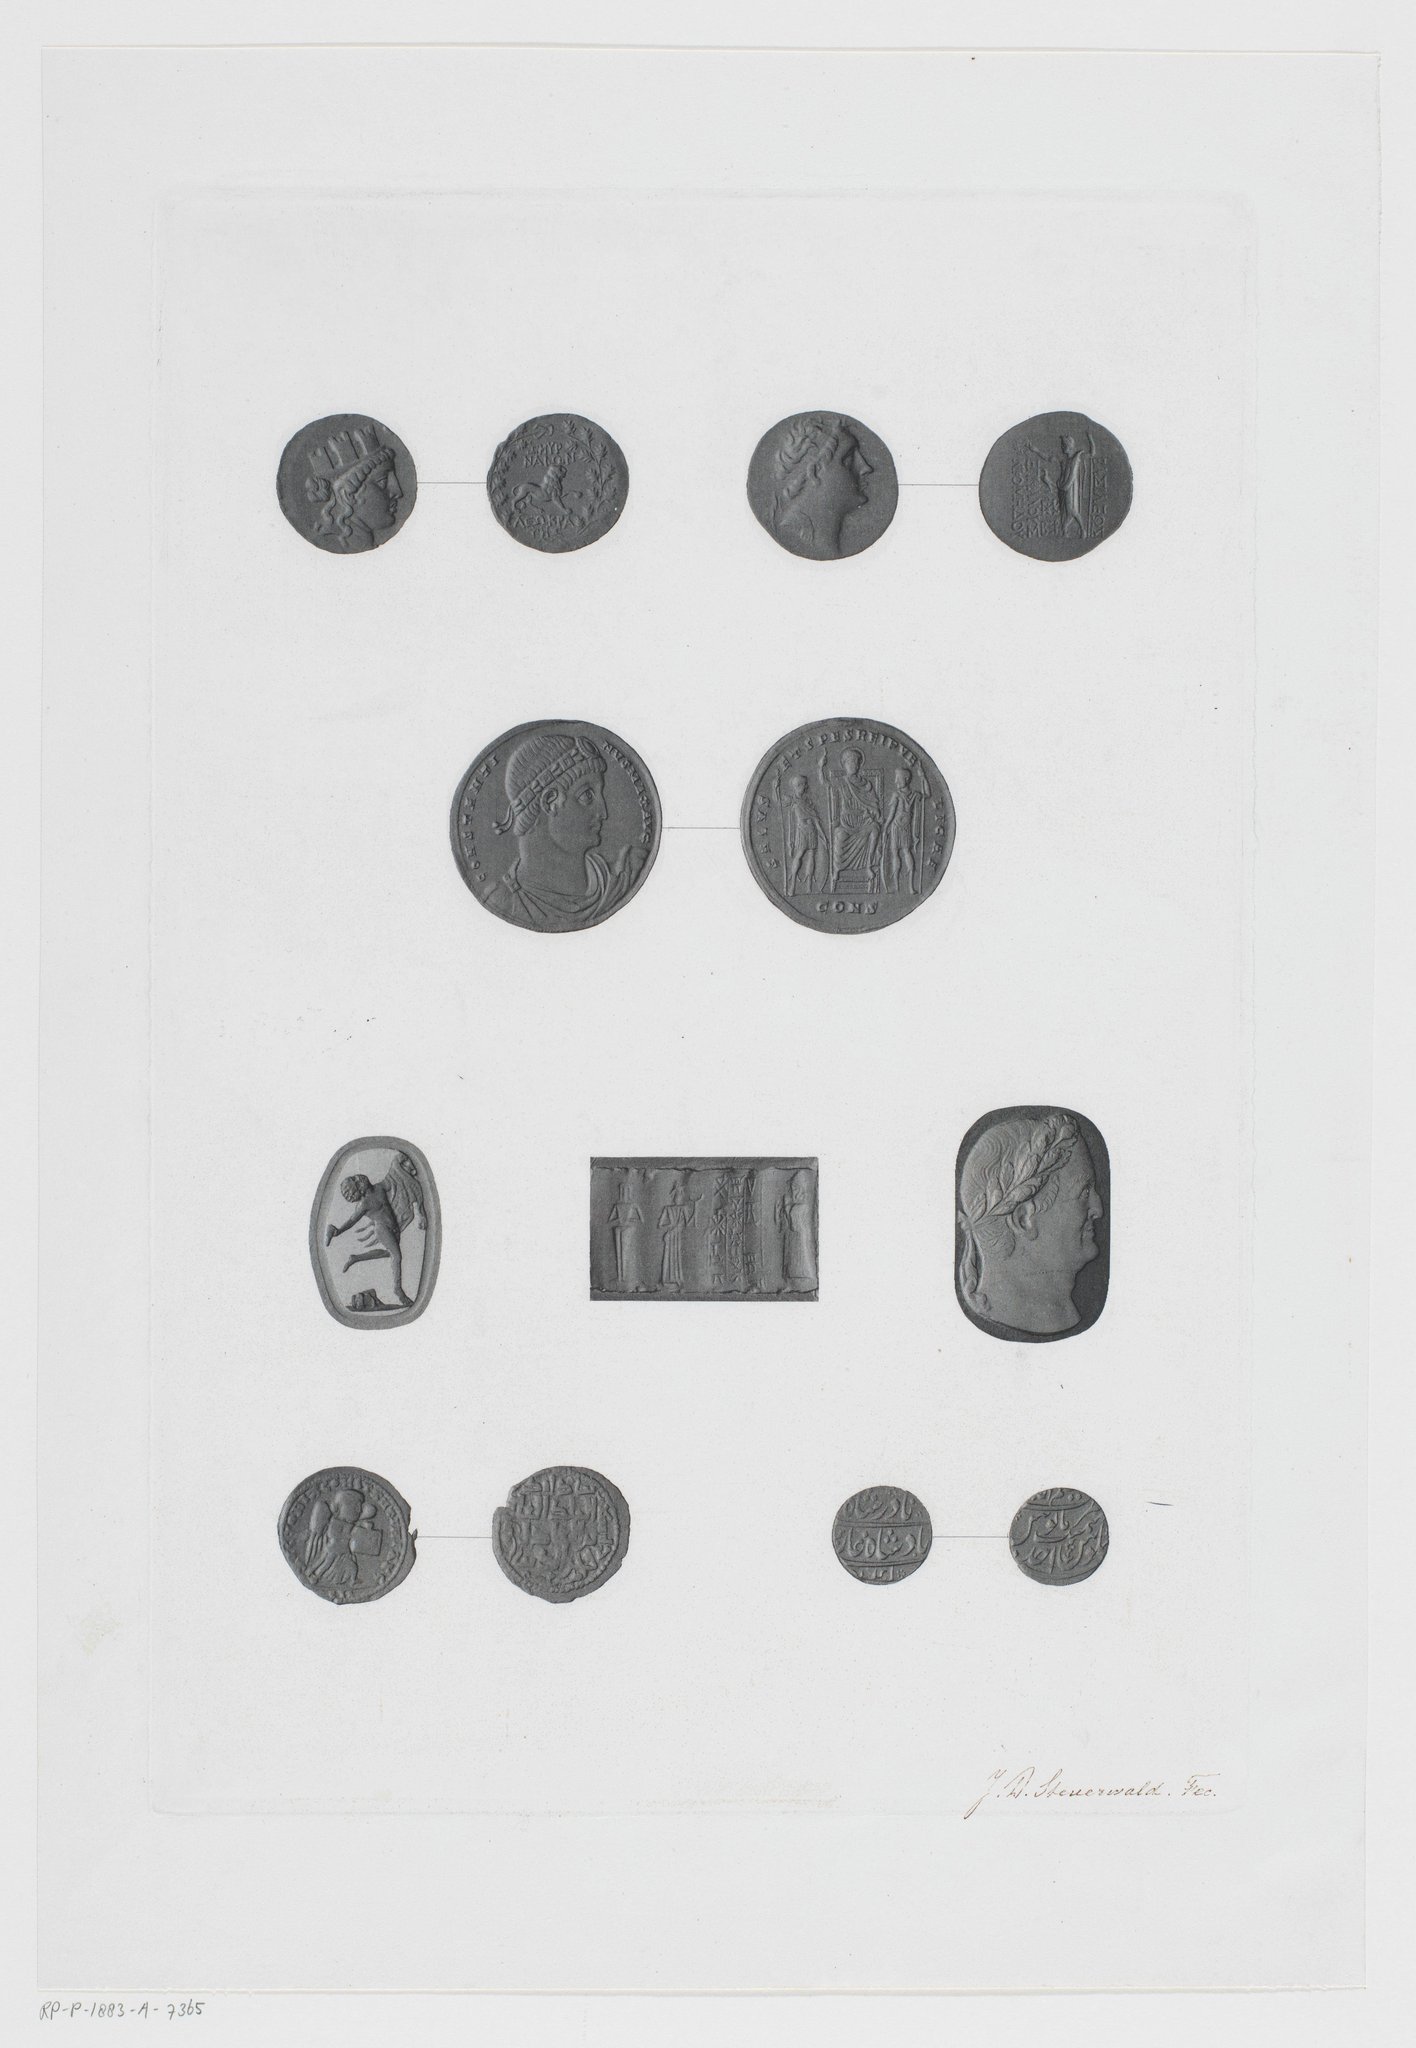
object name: print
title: Munten en gesneden stenen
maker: jan dam steuerwald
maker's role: print maker, printer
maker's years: 1805-1869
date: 1839-1863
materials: paper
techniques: relief engraving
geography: netherlands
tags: piece of sculpture, reproduction of a piece of sculpture, coin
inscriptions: inscription: ‘J.D. Steuerwald. Fec.’, collector's mark: Lugt 2228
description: De voor- en achterzijde van vijf munten. Daarnaast een steen met een vliegende naakte jongeling, een rechthoekige steen en een steen met het portret van een Romeinse keizer.